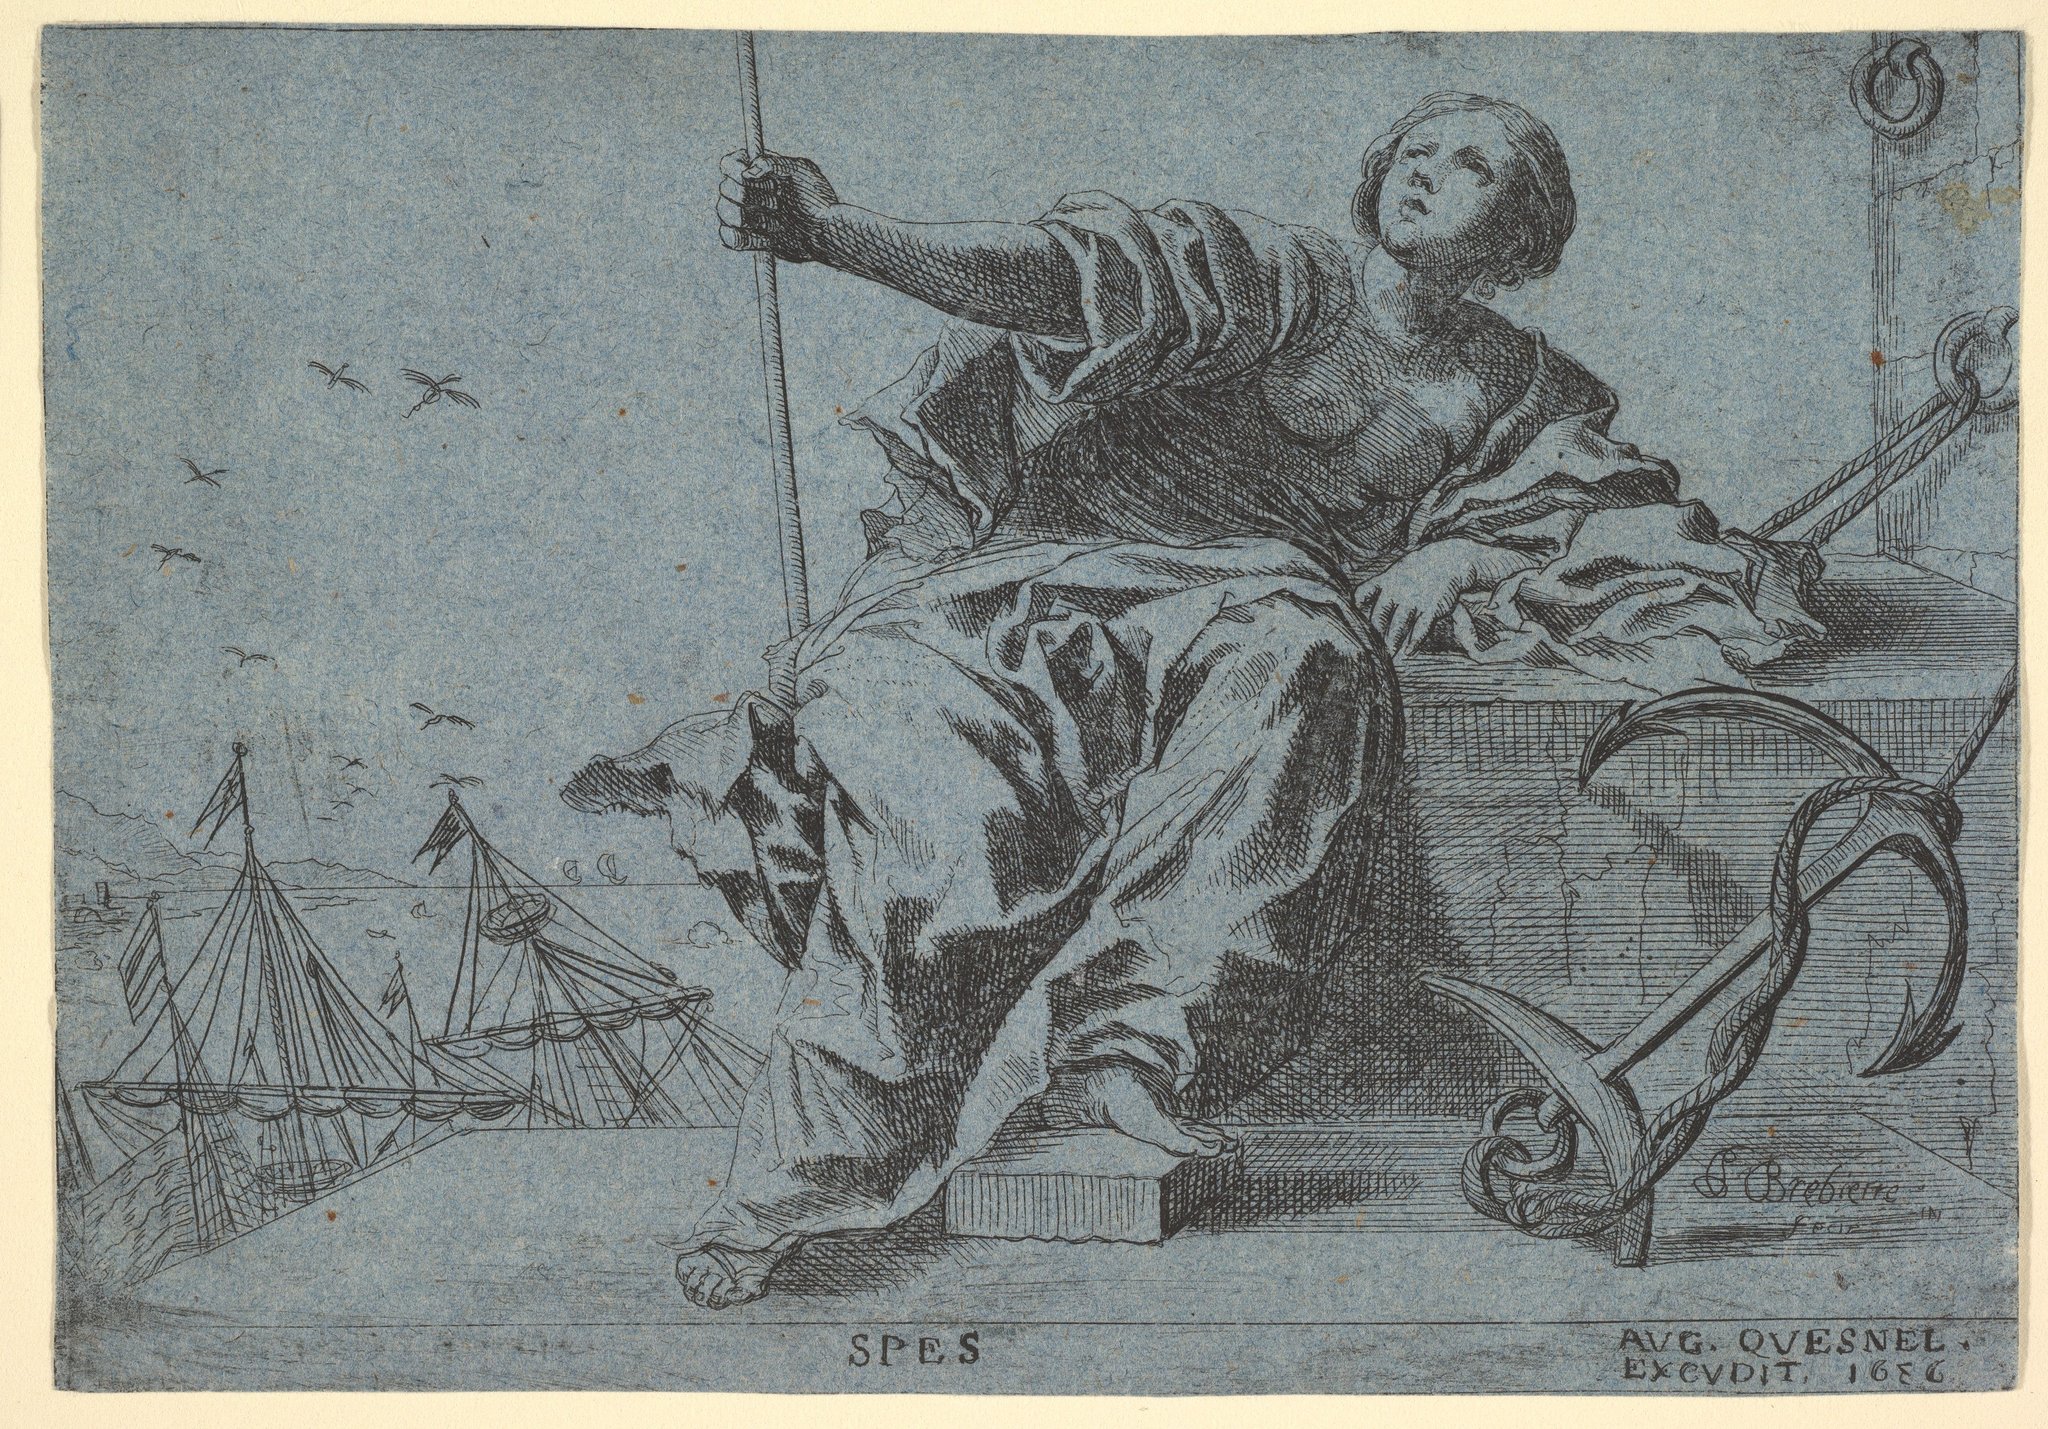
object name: print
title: Hope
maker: pierre brebiette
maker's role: artist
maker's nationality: french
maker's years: 1598-1642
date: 1601-1700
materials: paper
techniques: etching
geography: france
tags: birds,women,ships